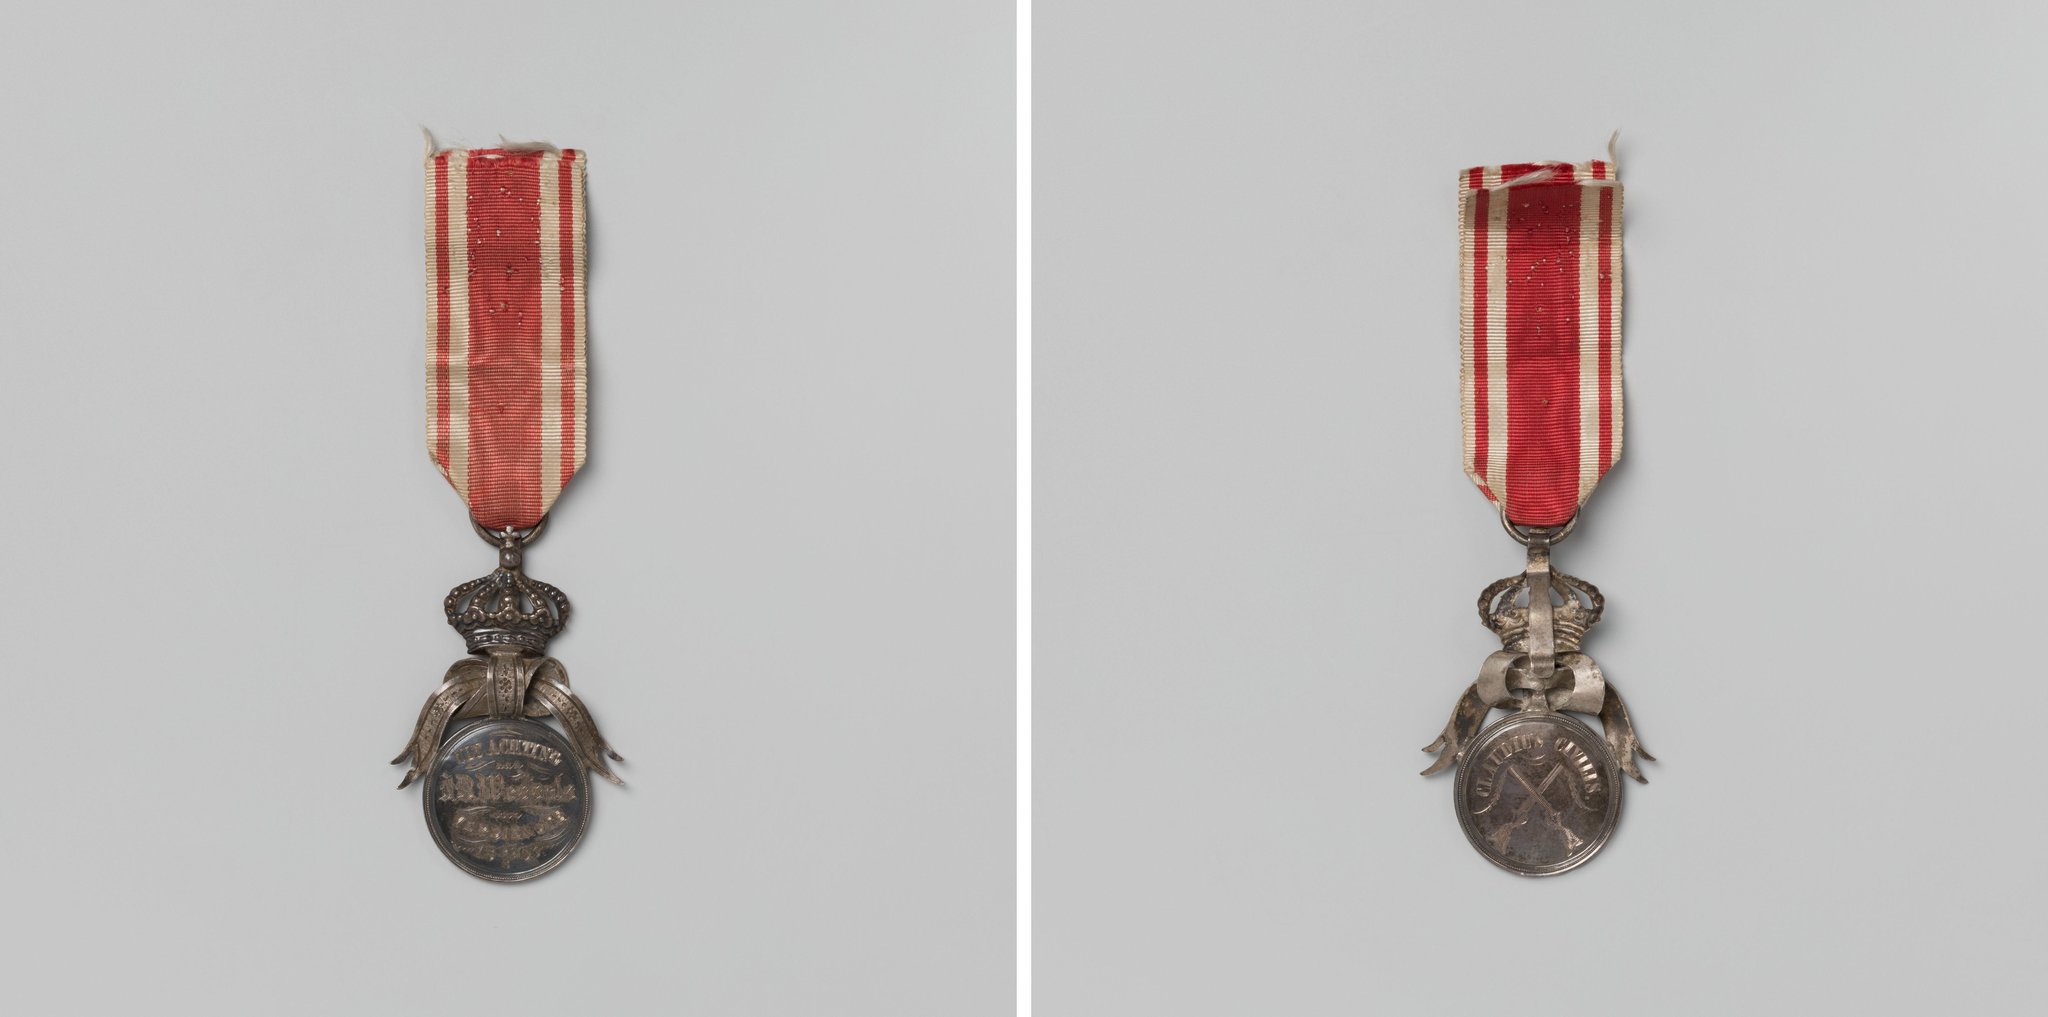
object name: marksman medal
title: Koninklijke handboogschutterij en weerbaarheidsvereniging Claudius Civilis te Amsterdam, penning uitgereikt aan J.D. Wessels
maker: Anonymous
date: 1863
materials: silver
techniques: casting, engraving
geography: amsterdam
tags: amsterdam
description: Zilveren ronde tweezijdige penning, daarop gemonteerd kroon op gestrikt lint aan draagoog en lint met zeven verticale banen in rood en wit van ongelijke breedte. Voorzijde: opschrift. Keerzijde: twee gekruiste geweren met uit loop hangende bladertak binnen omschrift.